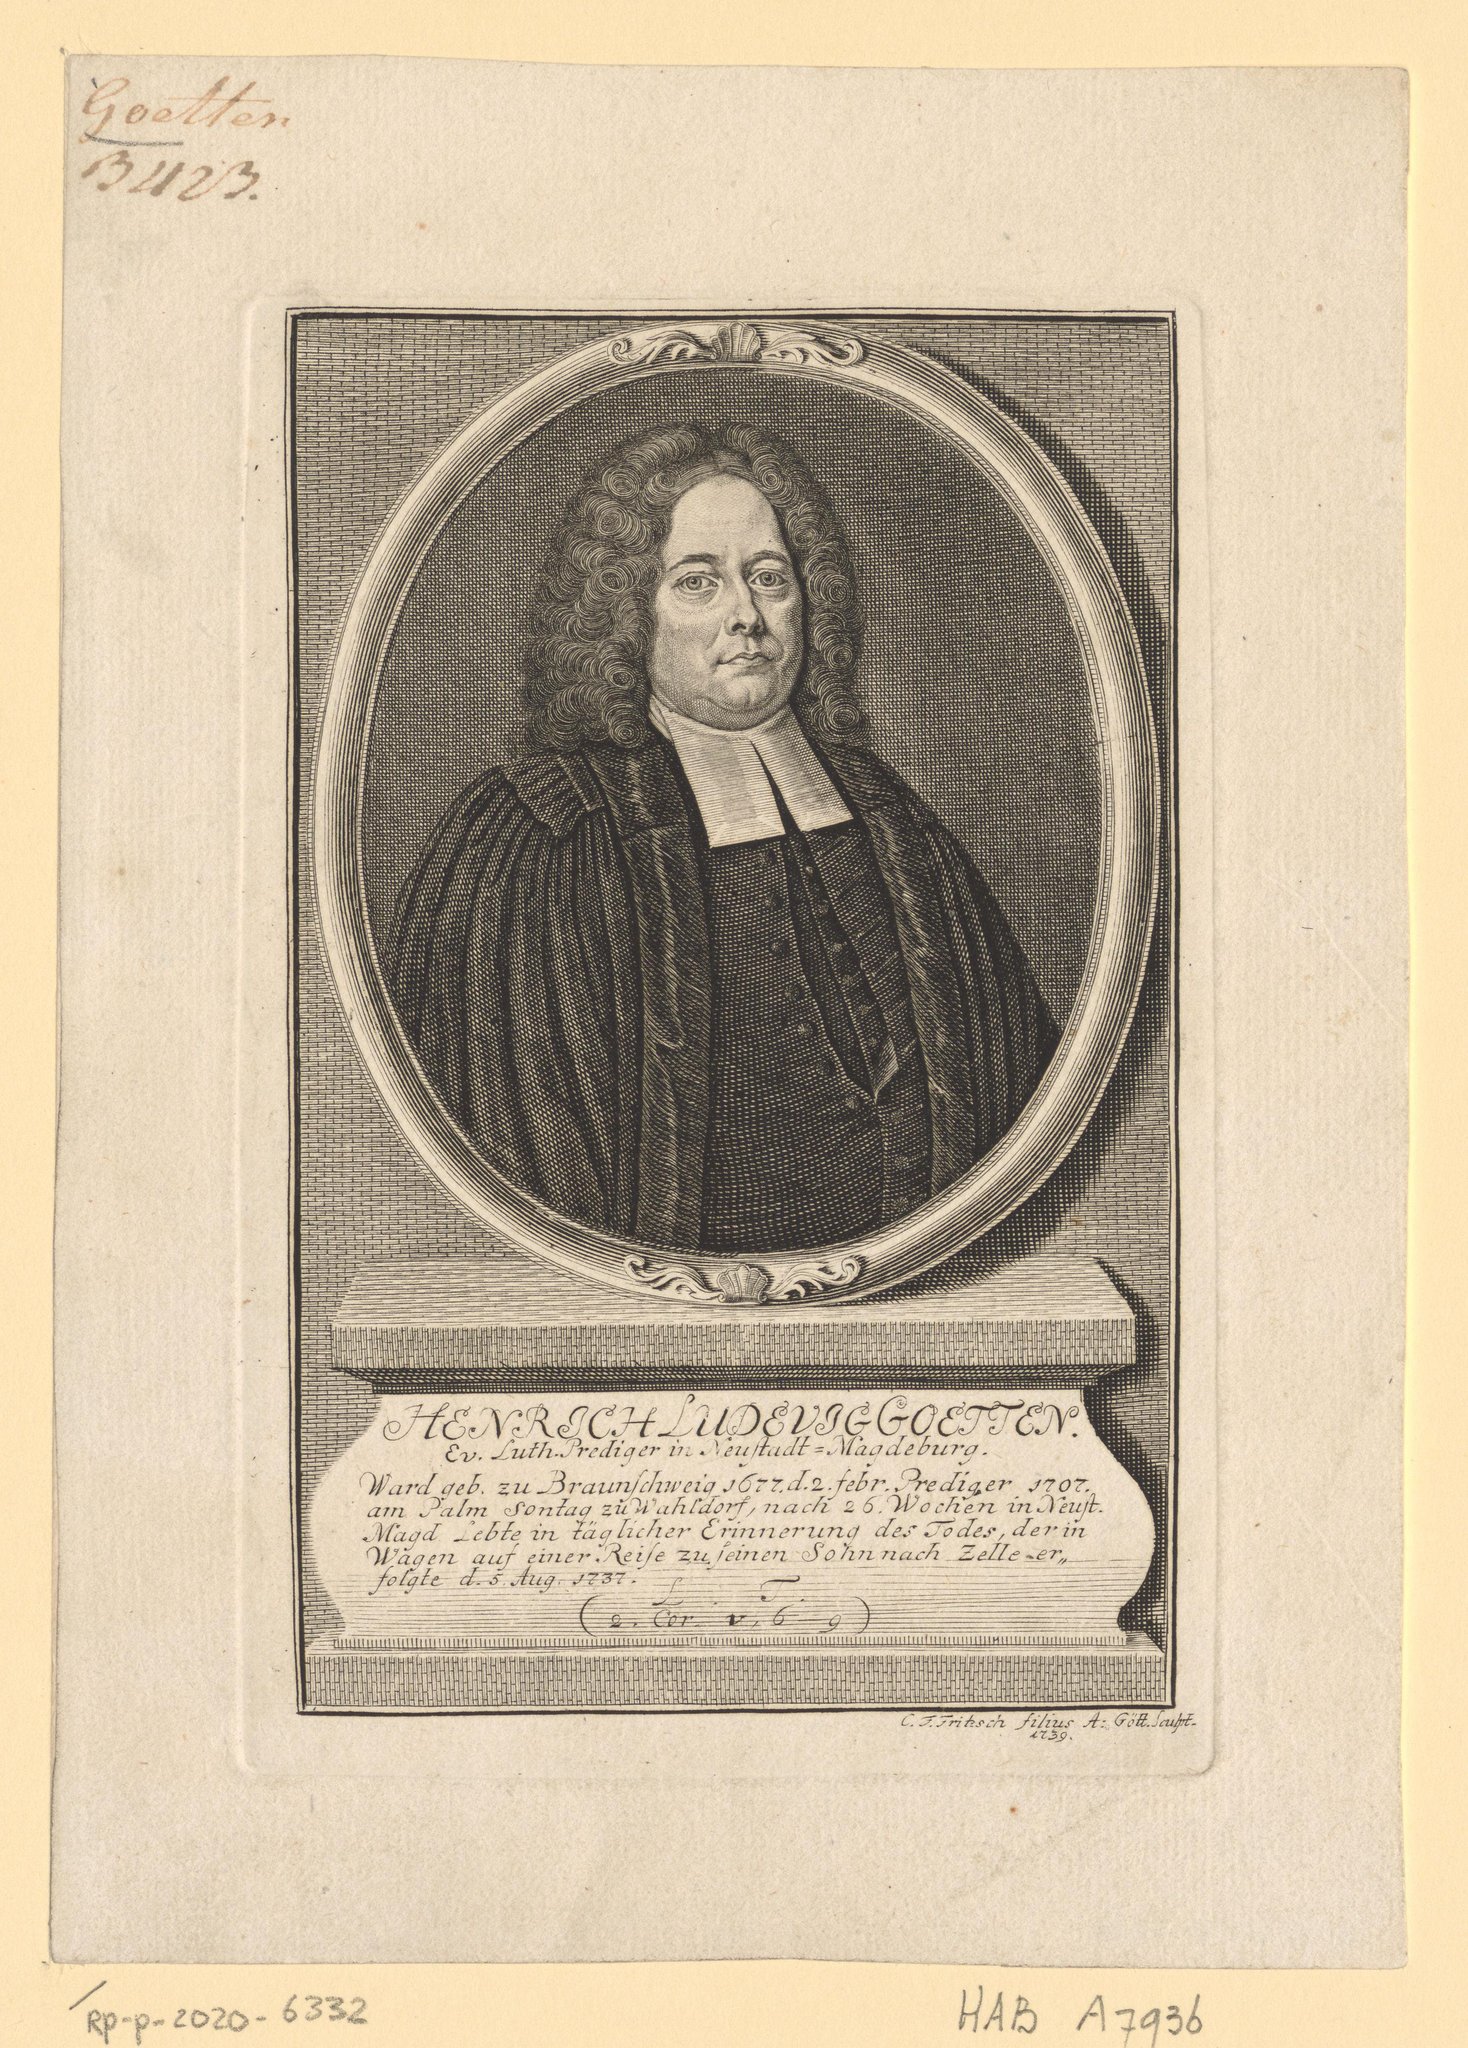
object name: print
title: Portret van Heinrich Ludwig Goetten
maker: christian friedrich fritzsch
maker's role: print maker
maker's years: 1719-1774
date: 1737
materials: paper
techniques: engraving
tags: priest, theologian, historical persons